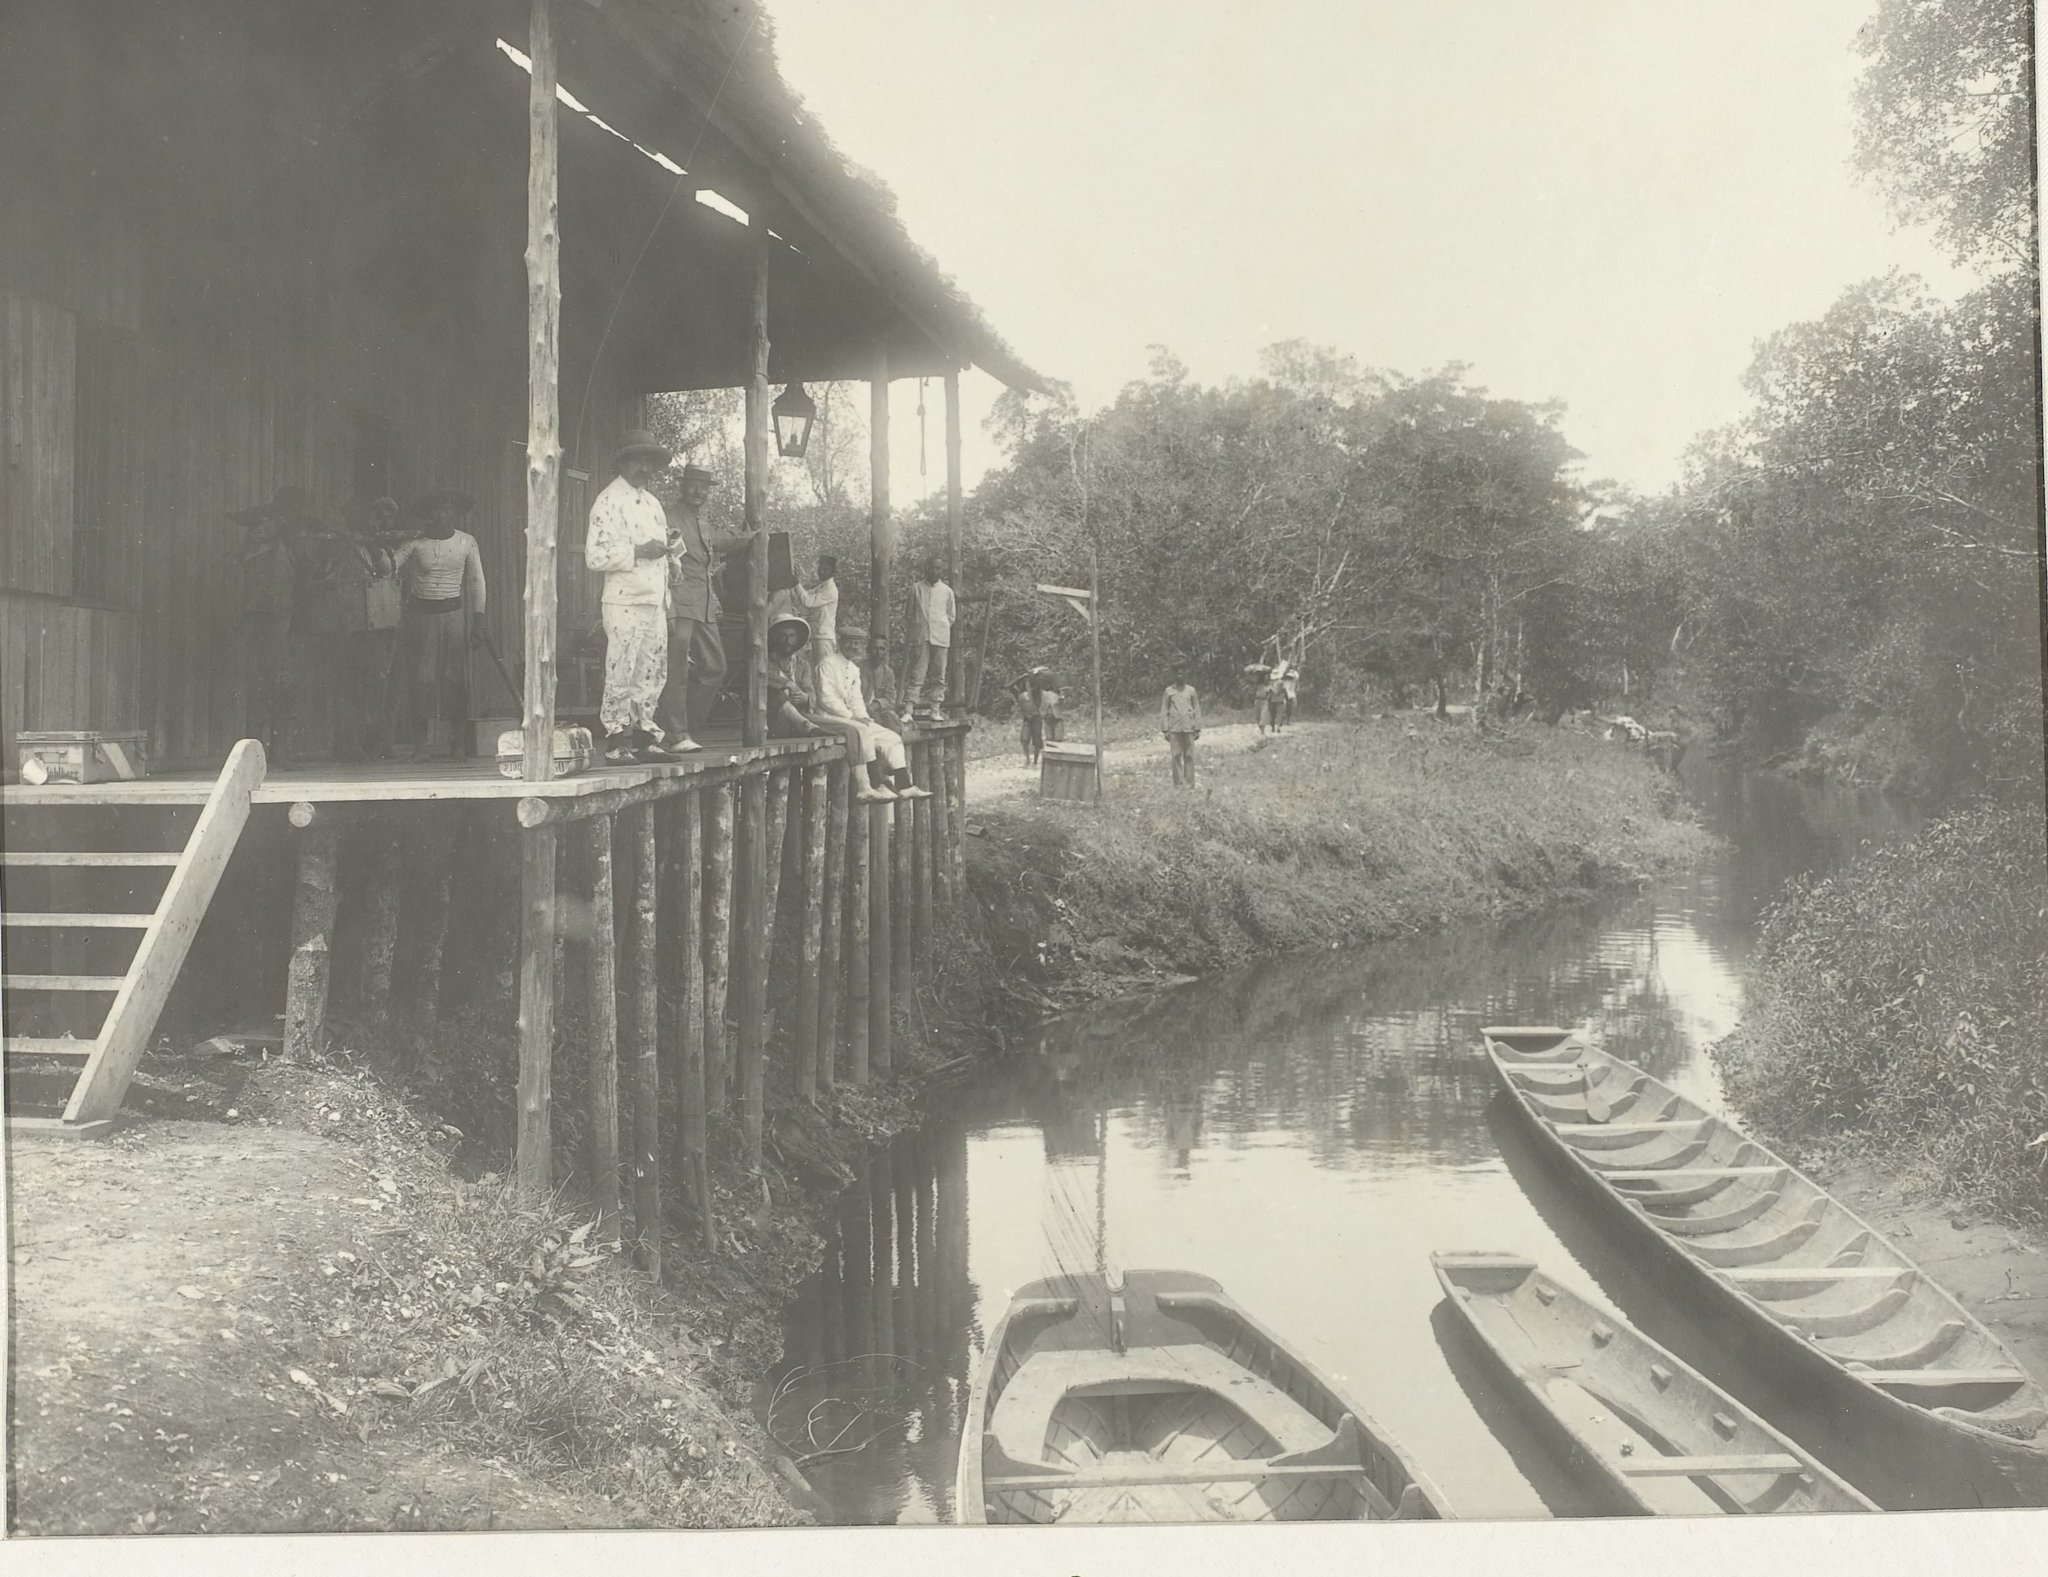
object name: album leaf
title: Veranda aan beek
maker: Anonymous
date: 1903-1907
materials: paper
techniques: gelatin silver print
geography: kalimantan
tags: small canal, ditch, borneo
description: Een groep Europeanen staand en zittend op een veranda aan de achterzijde van een gebouw op palen aan een riviertje. Foto in het fotoalbum over de oliewinning op Borneo door de Koninklijke Nederlandsche Petroleum Maatschappij (KNPM) in de jaren 1903-1907.